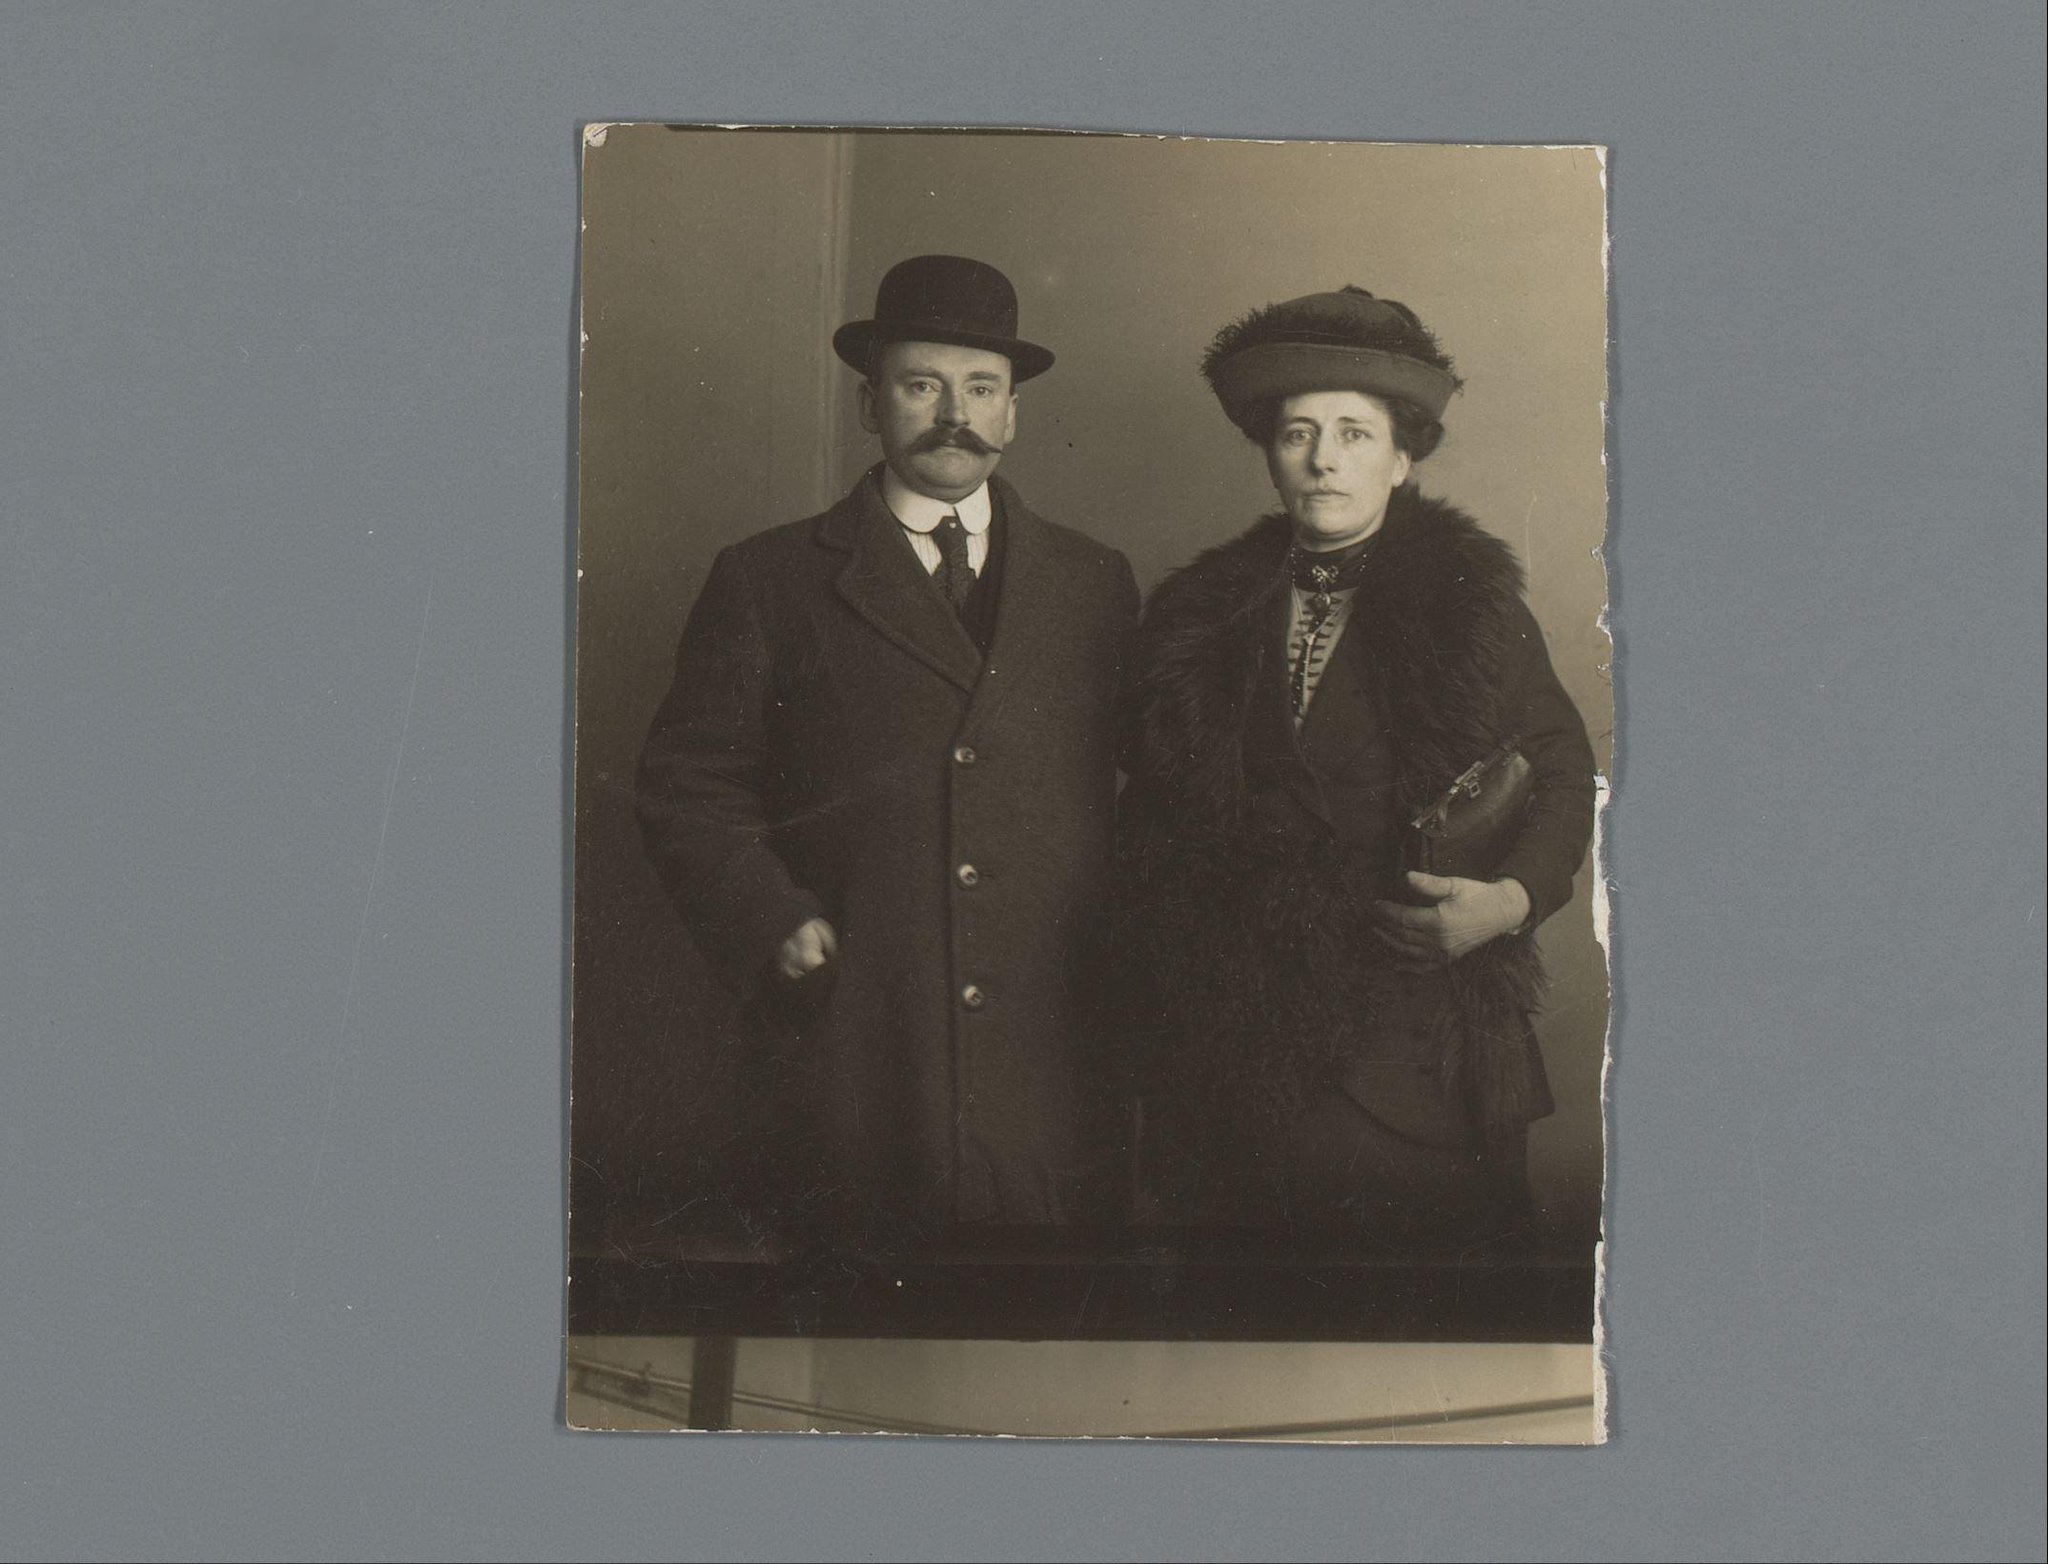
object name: snapshot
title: Rapid photographs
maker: Anonymous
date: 1912-1920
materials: paper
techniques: gelatin silver print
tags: adult woman, adult man, anonymous historical person portrayed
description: Between 1912 and 1930, anyone could have their portrait taken at the many so-called rapid photography studios in the shopping streets of mainly (medium) large-size European cities. As if on an assembly line, the youngest clerk shot the photographs with a special camera and in artificial light and developed them. Later in the day, the customer collected a sheet with 12 portrait photos for 25 cents. This form of photographic mass production gave rise to a fascinating tableau of boys, girls, men and women not previously seen in photographs; candid and informal. There were at least 150 quick-photo studios, from Alkmaar to Zutphen. Many called themselves ‘American,’ mistakenly as it turns out because hardly any examples from that country have been found.